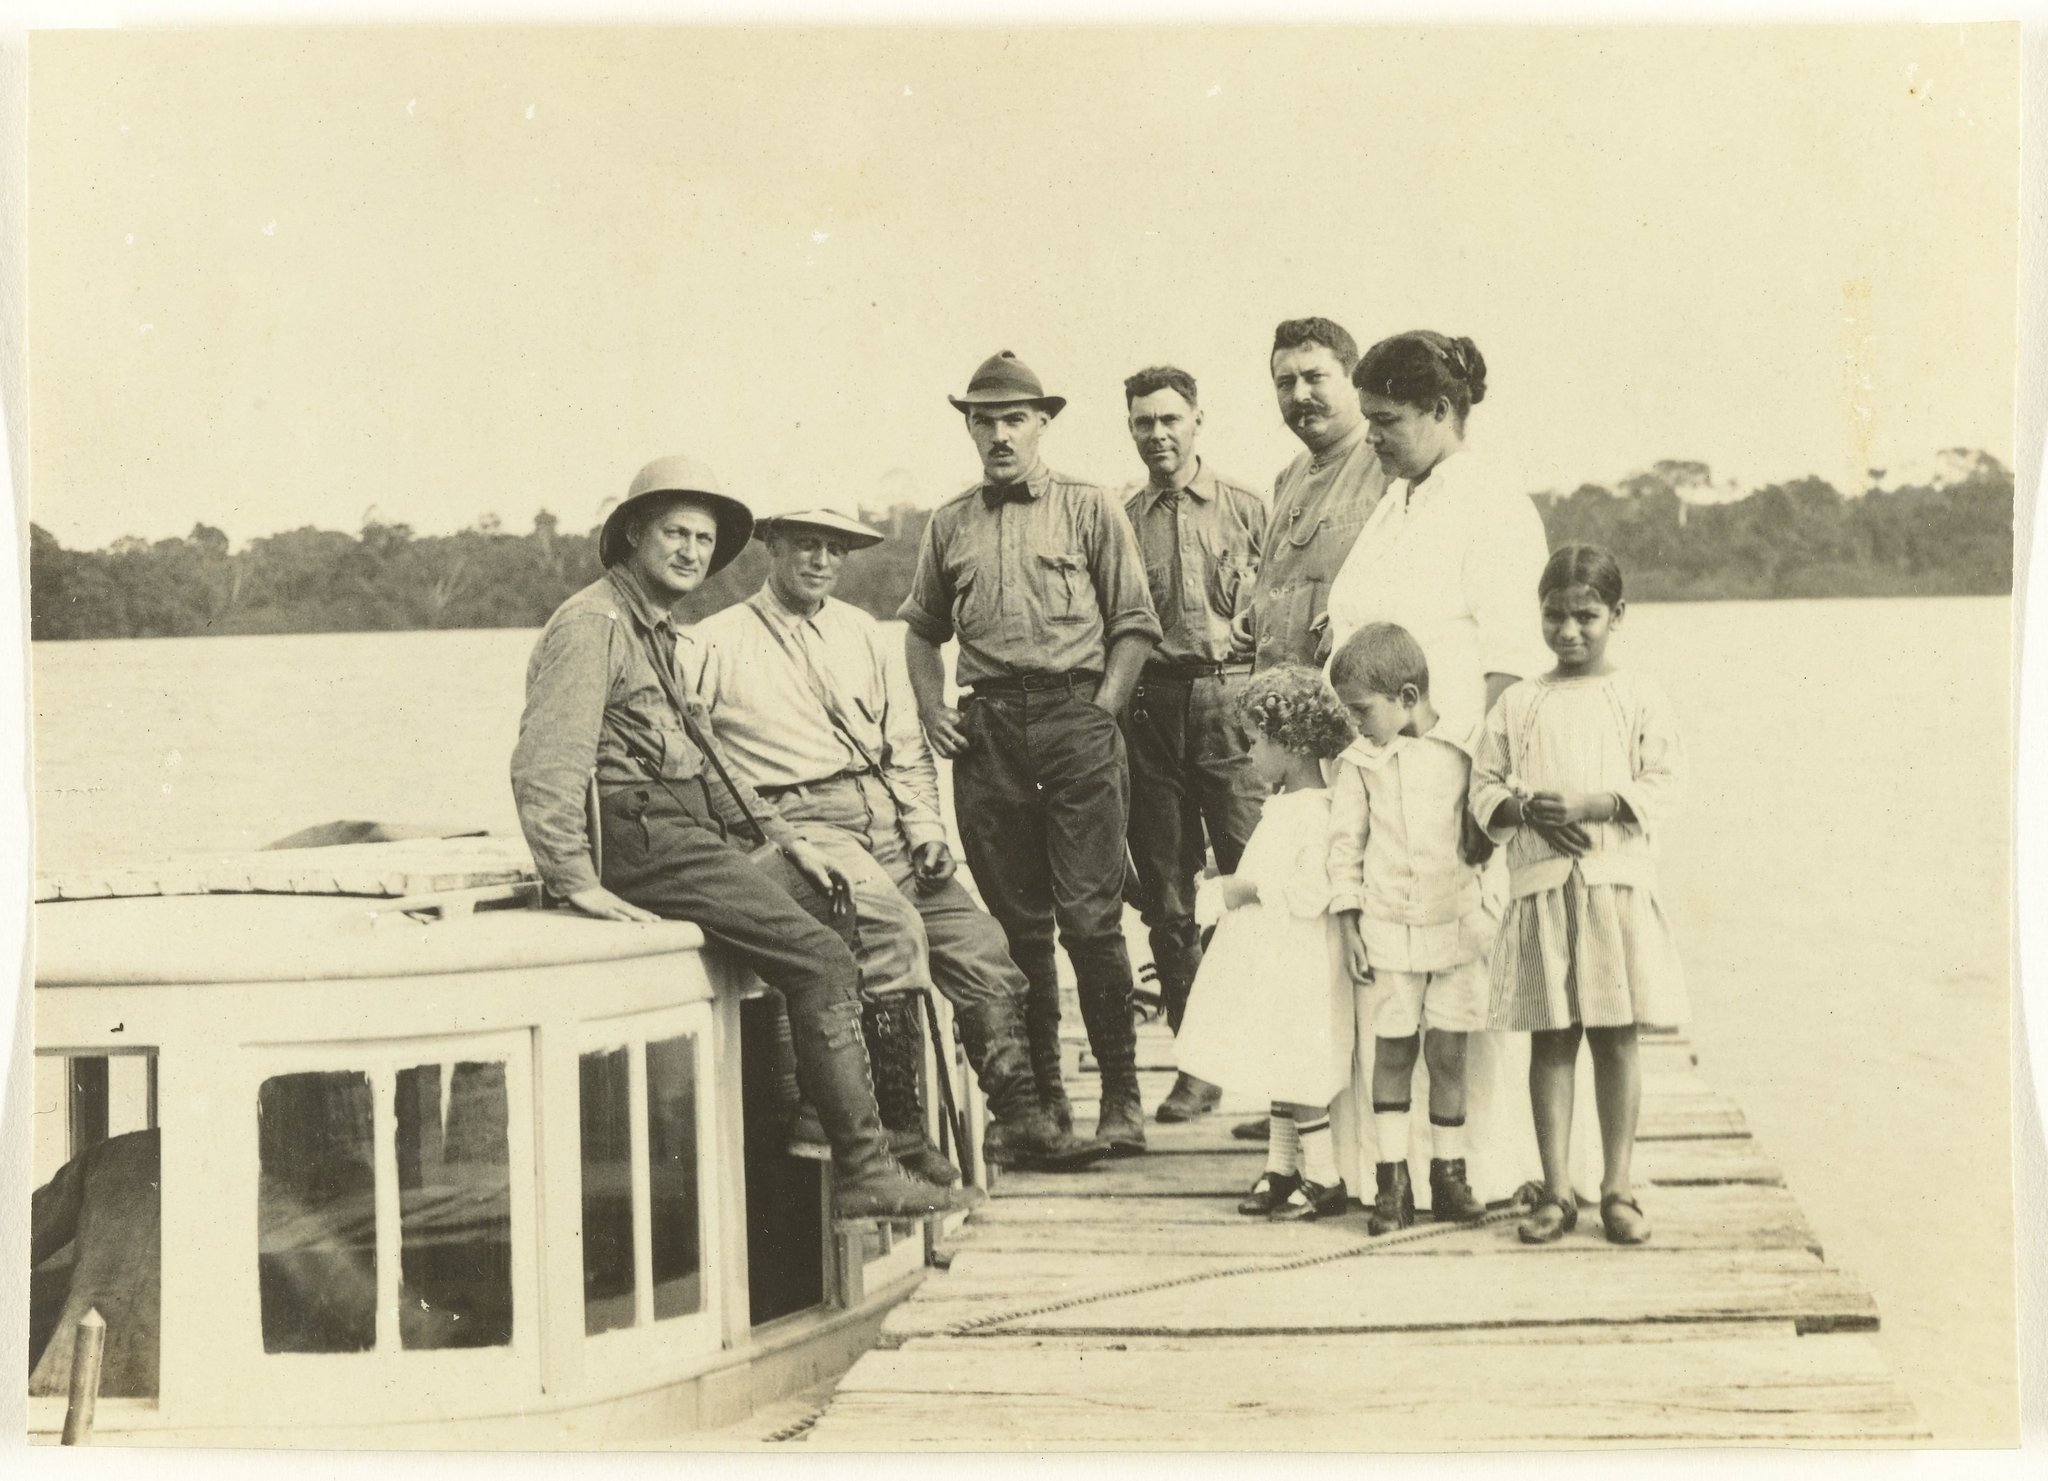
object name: photograph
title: Groepsportret bij steiger op plantage Accaribo te Suriname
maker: Anonymous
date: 1916-1930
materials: photographic support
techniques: photography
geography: suriname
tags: theodoor brouwers, plantation, suriname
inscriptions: inscription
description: In de periode 1911-1932 woonde op plantage Accaribo in Suriname de familie Brouwers van wie de foto's afkomstig zijn. Rond 1910 vond Theodoor Brouwers werk op plantage Accaribo. In 1929 werd hij eigenaar van de plantage.